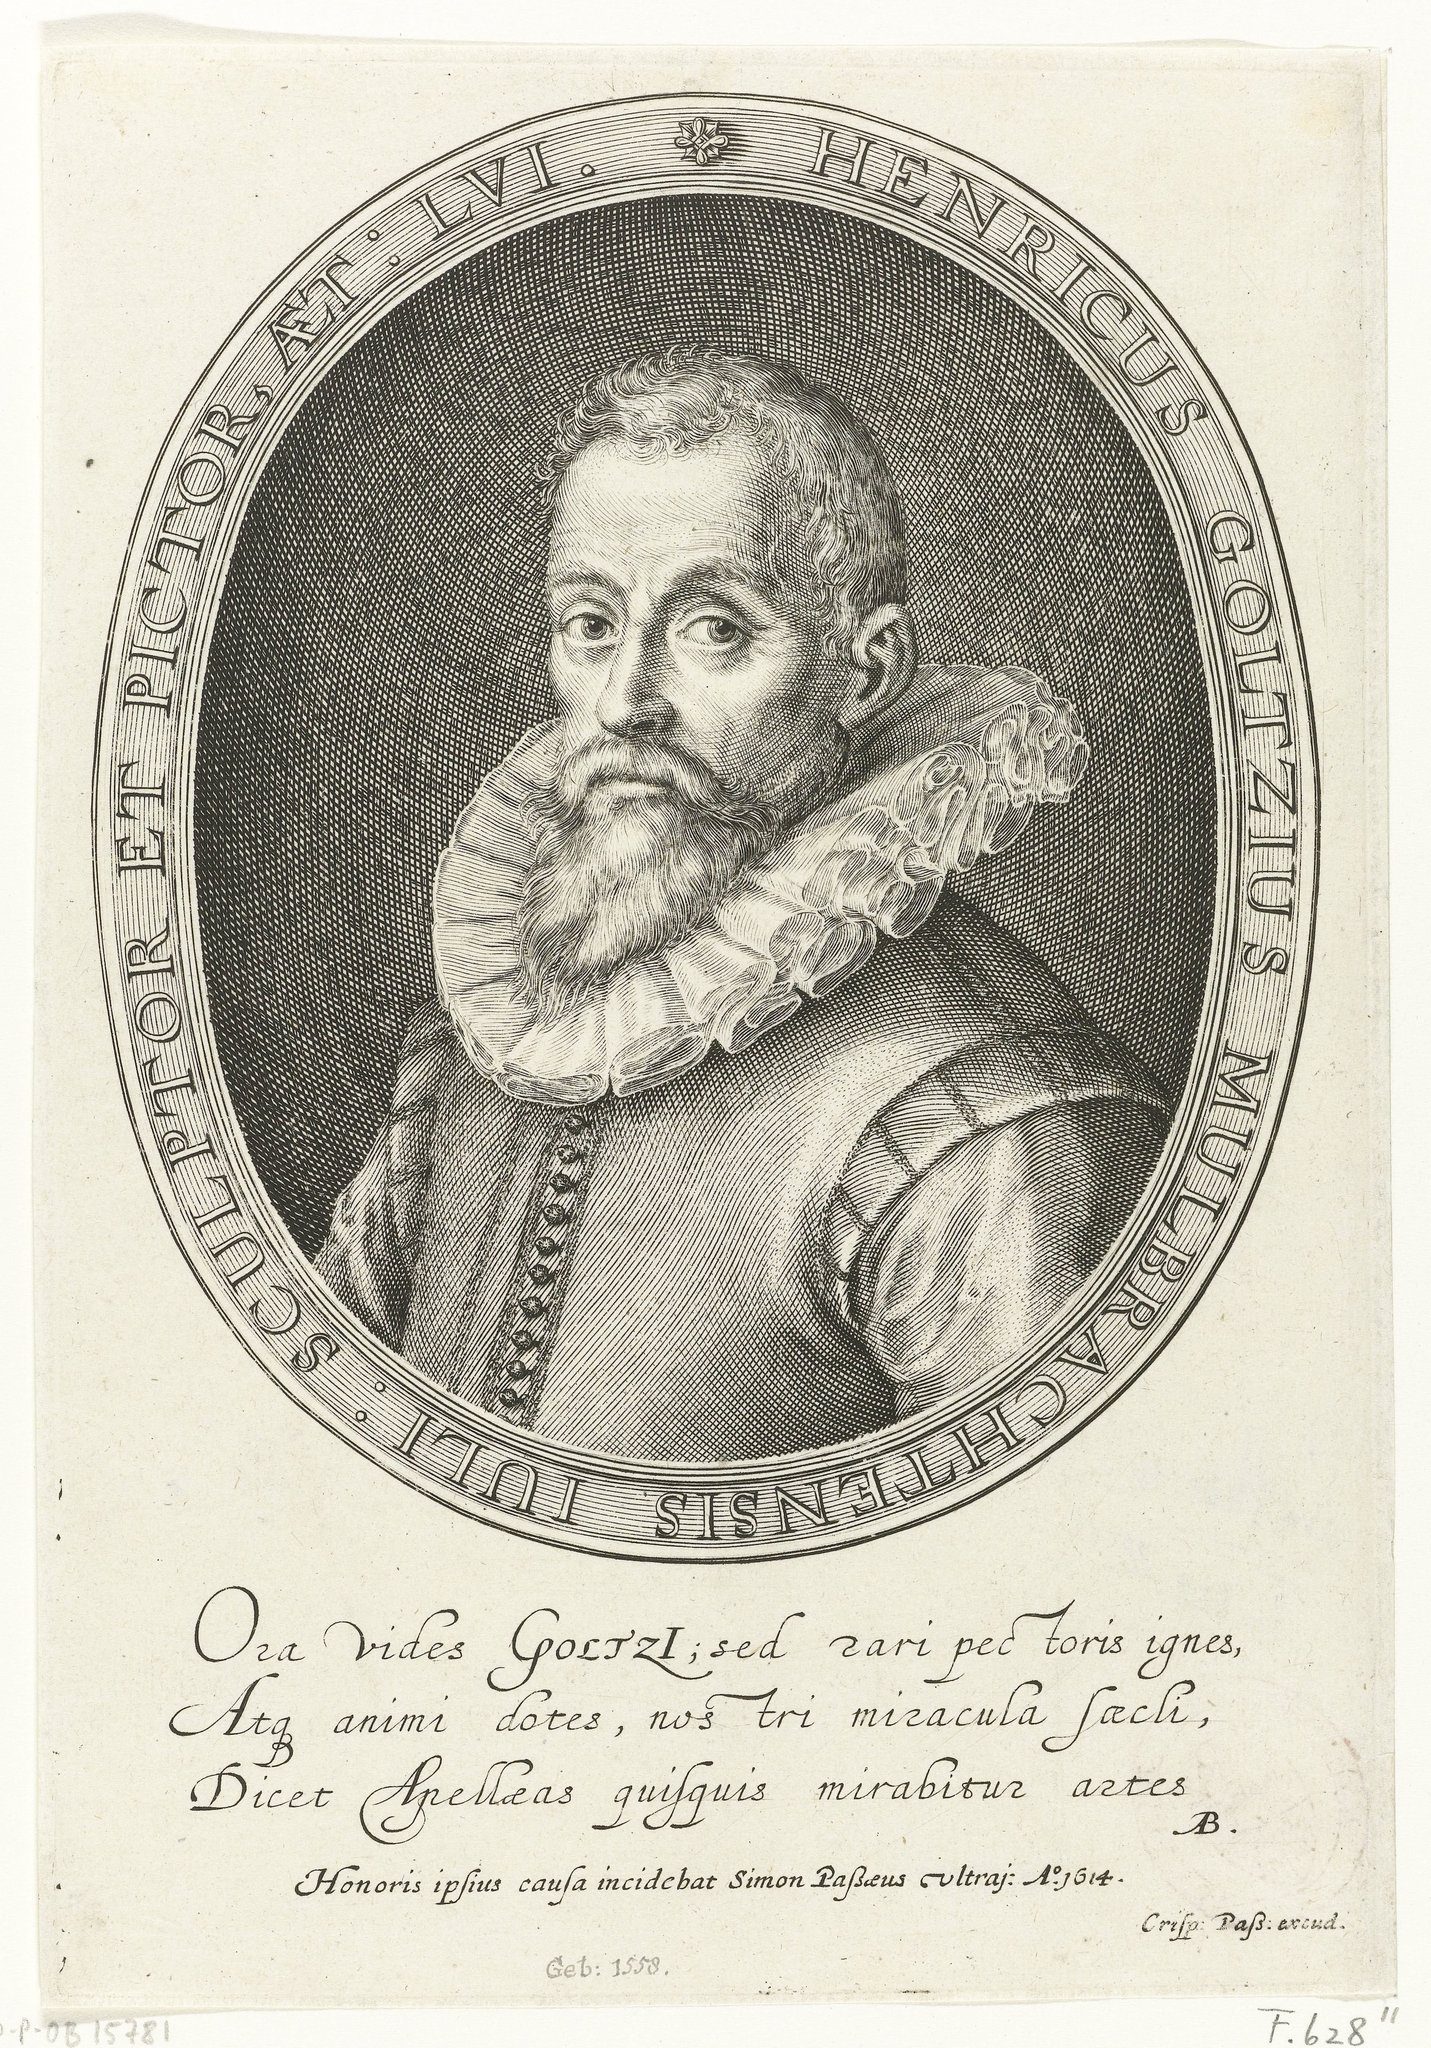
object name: print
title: Portret van Hendrick Goltzius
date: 1614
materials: paper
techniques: engraving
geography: utrecht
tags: neck-gear ~ clothing (with name) (+ men's clothes), moustache, portrait, self-portrait of painter, clothing for the upper part of the body (doublet) (+ men's clothes), beard, portrait, self-portrait of graphic artist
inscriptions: inscription: ‘Geb: 1558.’, collector's mark: Lugt 240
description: Portret van de kunstenaar Hendrick Goltzius, op 56-jarige leeftijd. In het randschrift van de omlijsting de naam, functie en leeftijd van de geportretteerde. In de marge een drieregelig lofdicht in het Latijn.